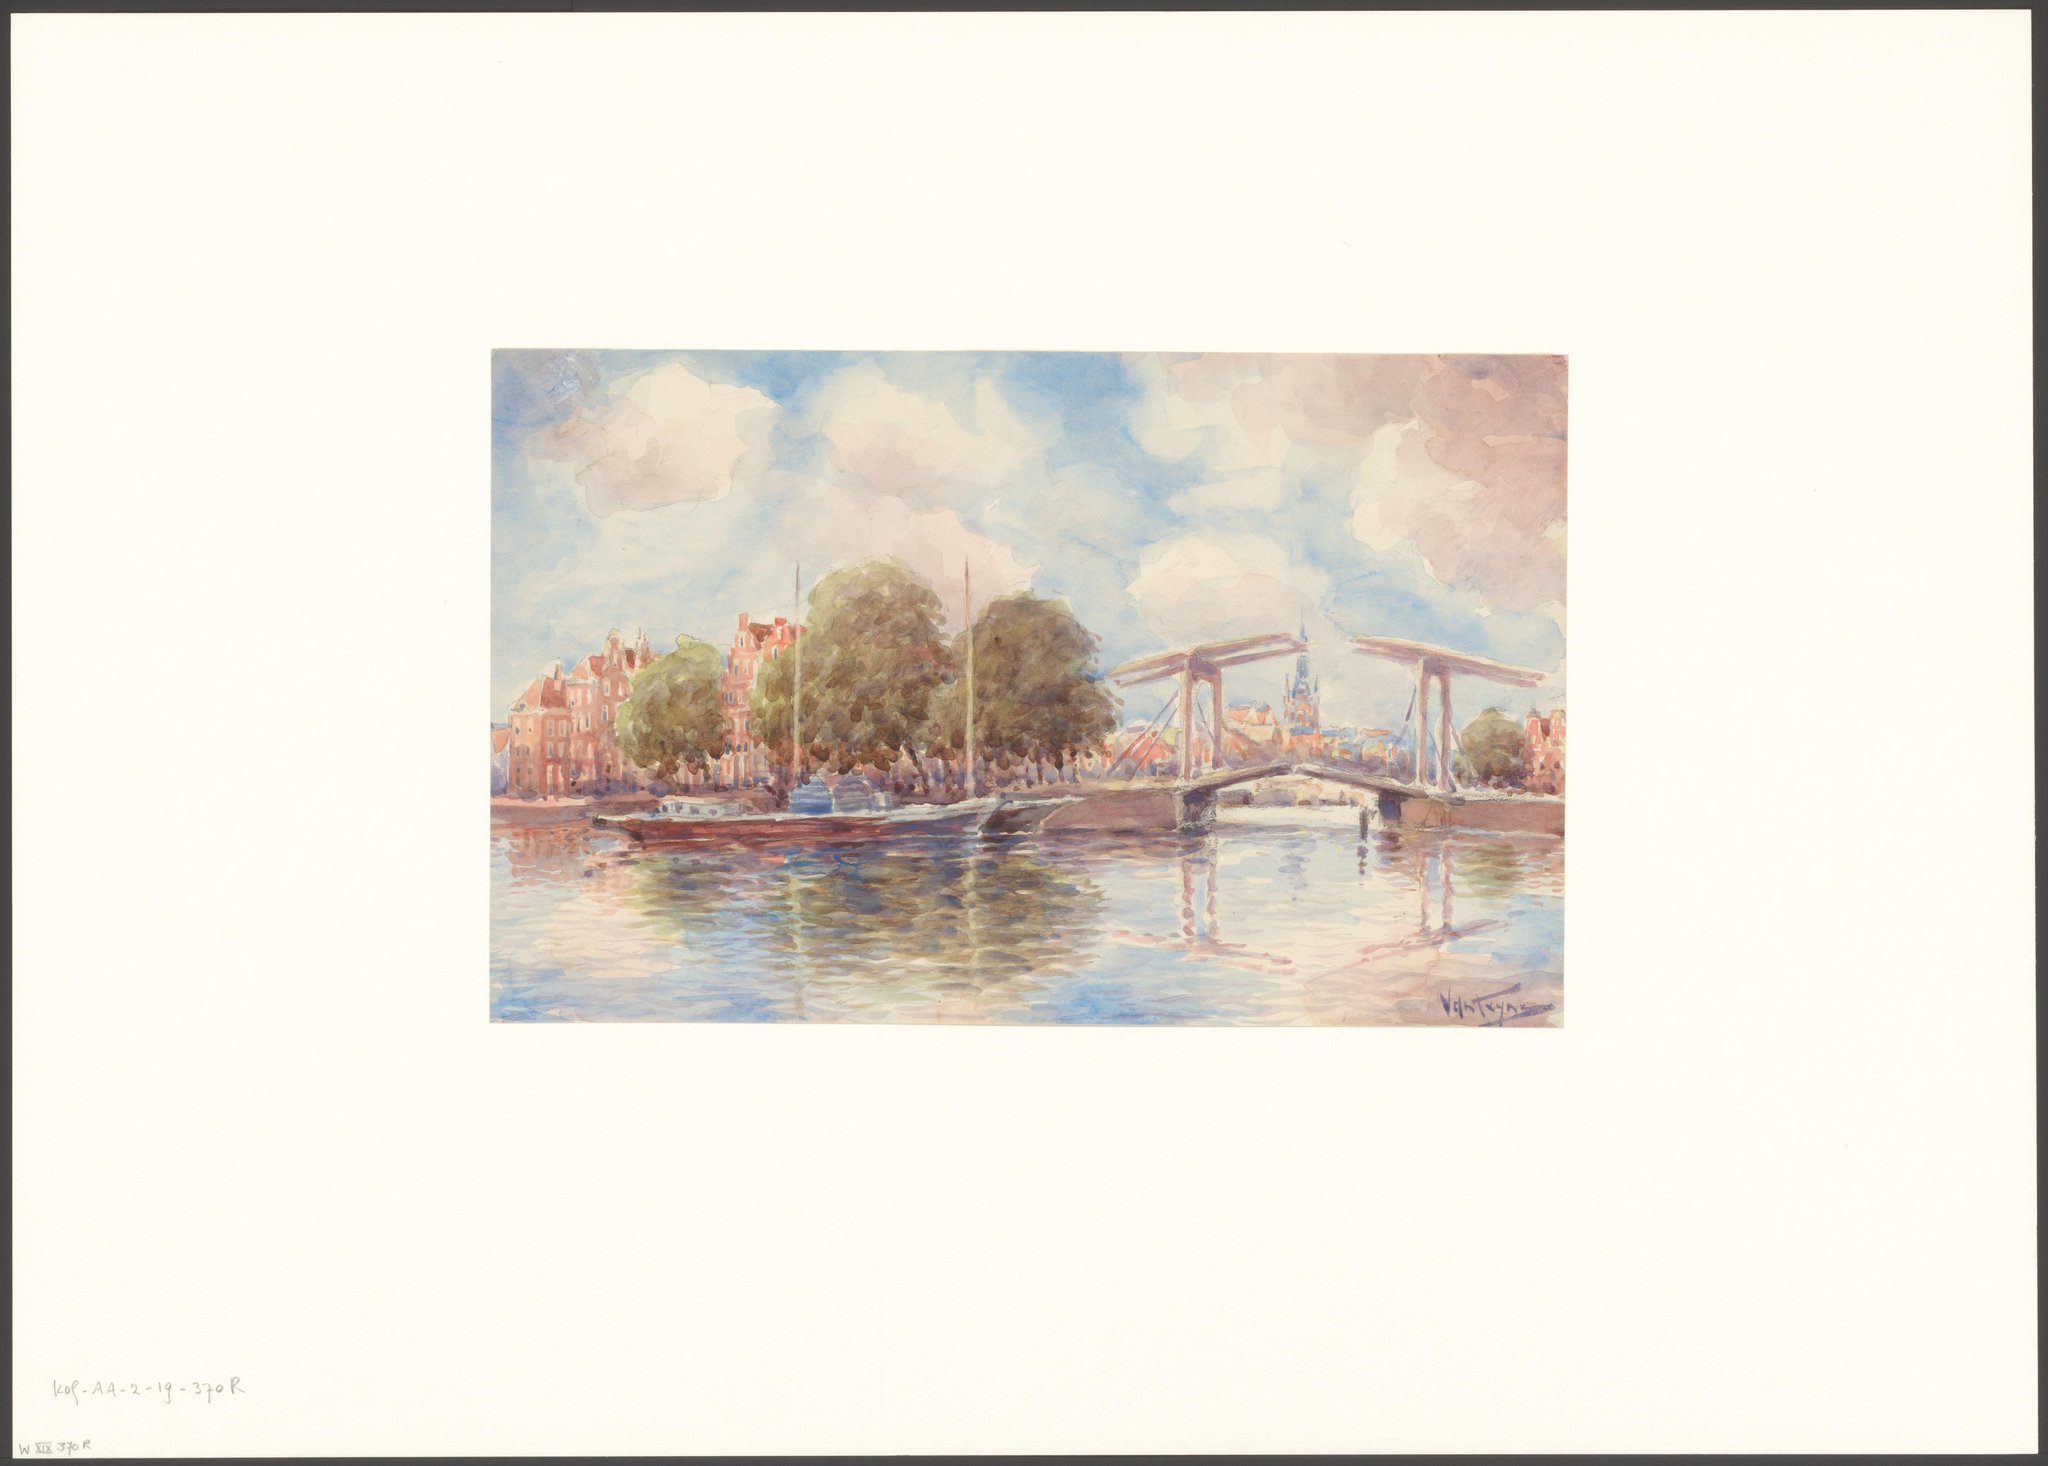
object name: drawing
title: Gezicht op de Zandhoek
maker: anthonie van teijn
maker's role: draughtsman, painter, print maker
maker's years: 1863-1943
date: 1873-1943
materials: chalk, paper, watercolor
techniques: brush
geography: amsterdam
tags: sailing-ship, sailing-boat, city-view in general; 'veduta', canal, bridge in city across river, canal, etc.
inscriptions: signature: ‘VanTeyne’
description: Tekening binnen de Atlas Van Eck ingedeeld op wijknummer 19.